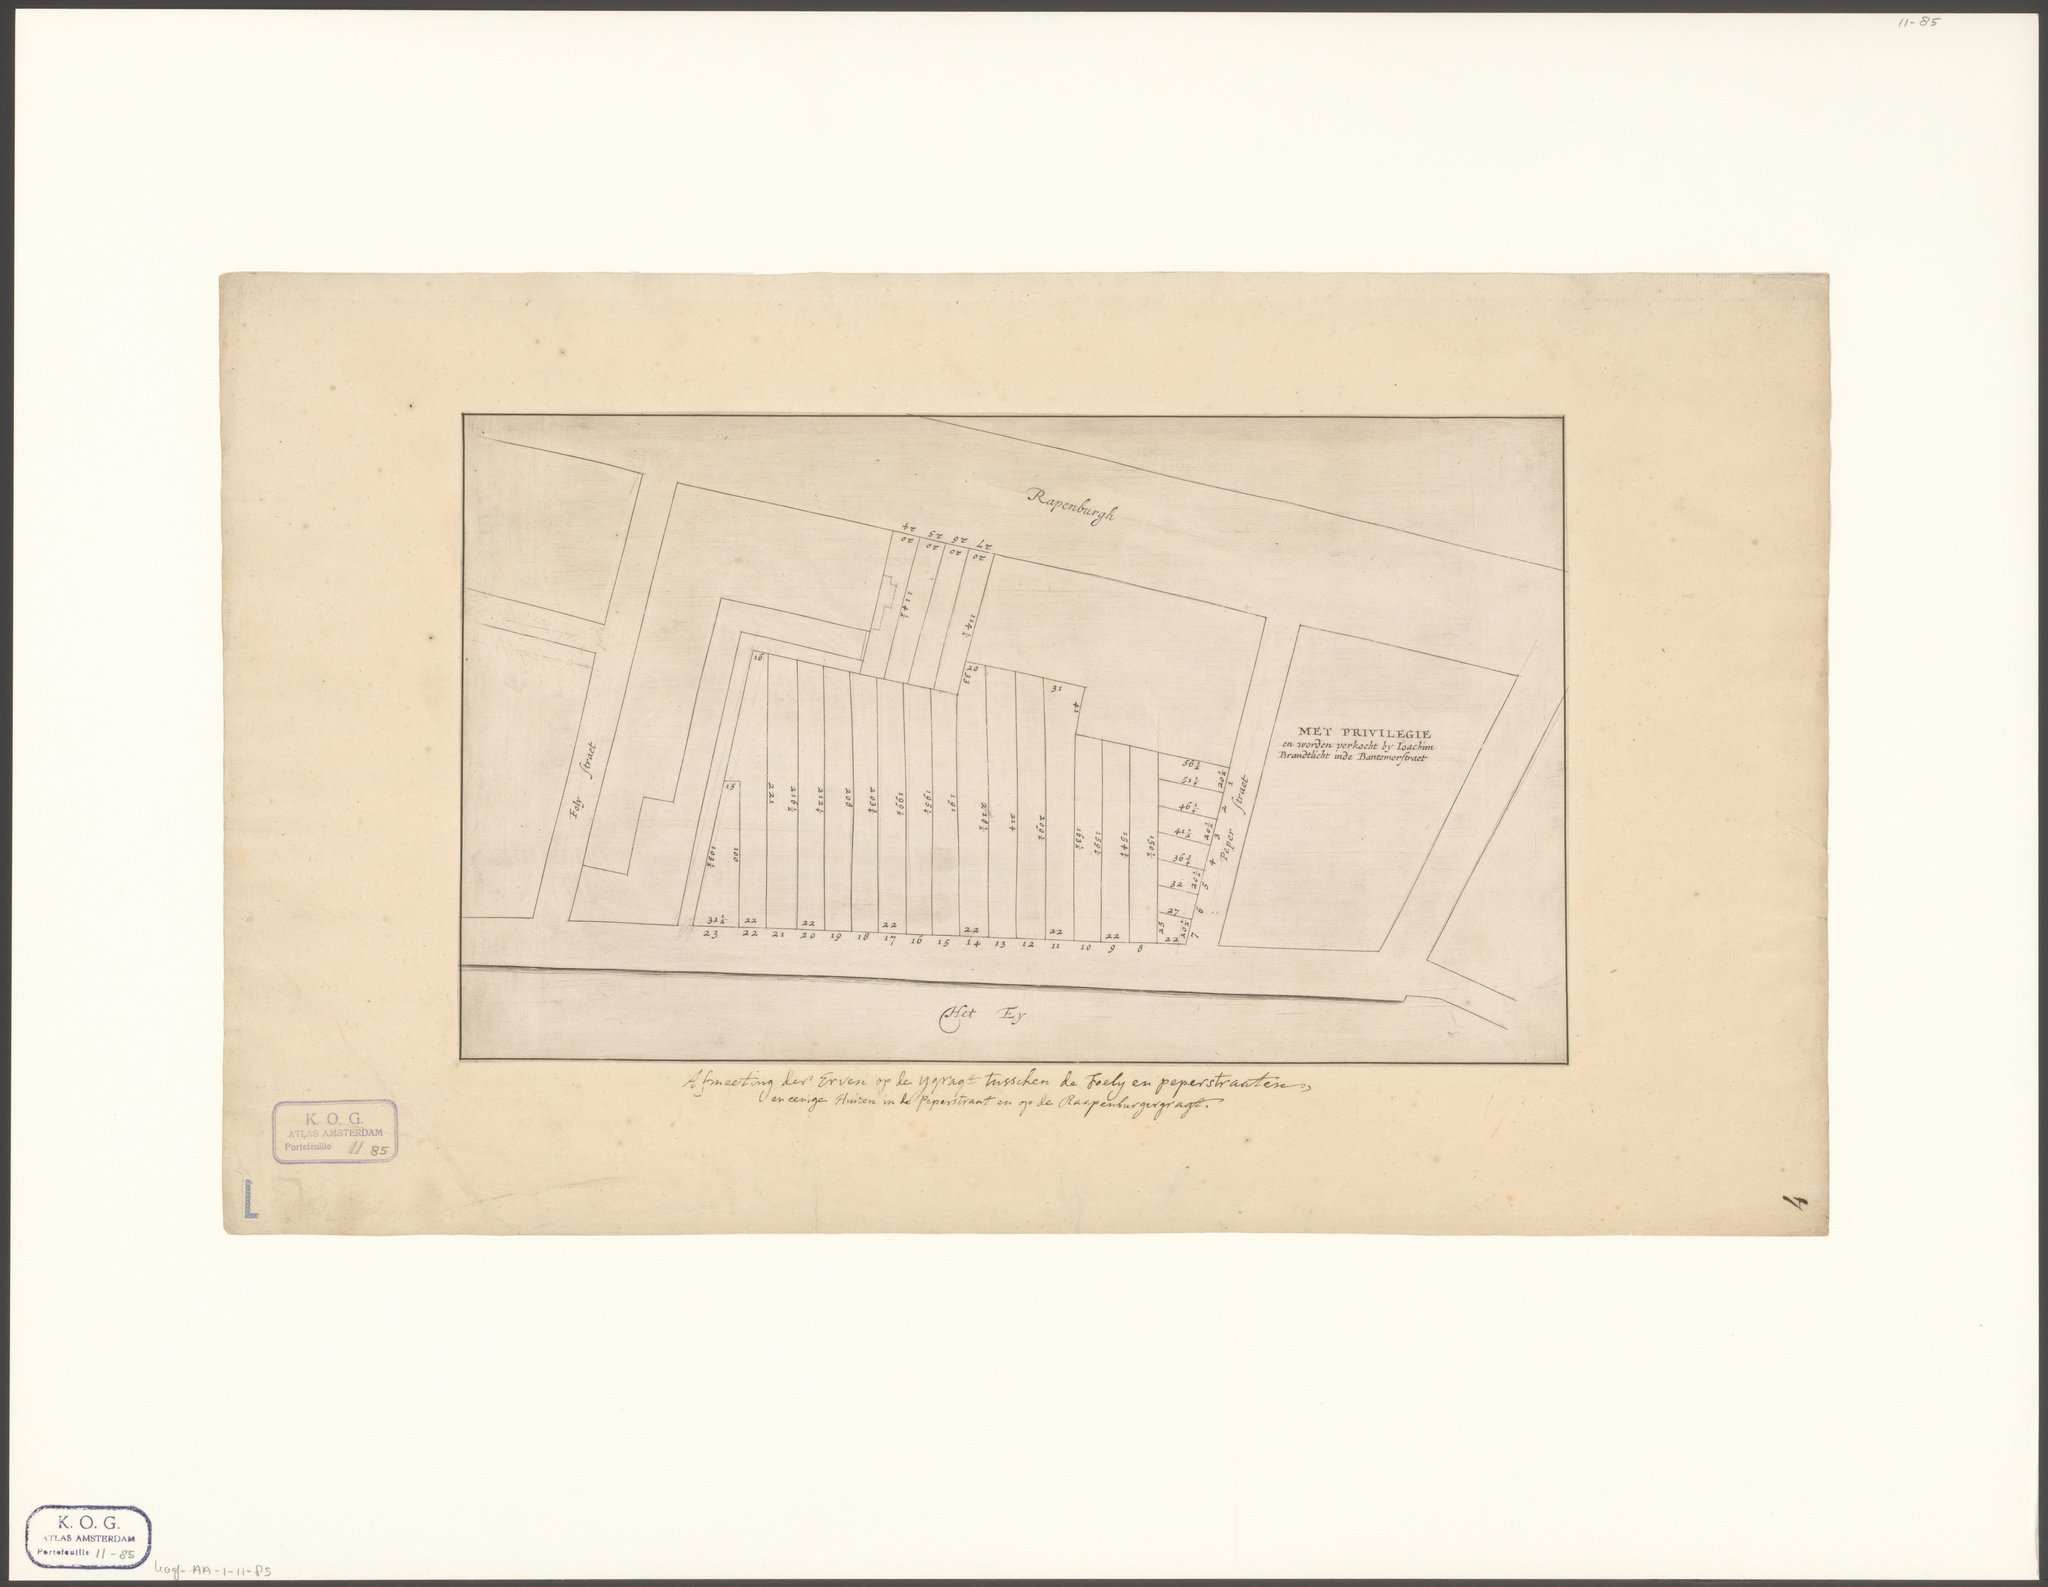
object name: area plan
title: Plattegrond van de percelen aan de IJgracht tussen de Foeliestraat en de Peperstraat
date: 1650-1750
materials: paper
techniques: engraving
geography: amsterdam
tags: plan ~ architecture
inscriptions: inscription: ‘Afmeeting der Erven (...) op de Raapenburgergragt.’, collector's mark: ‘11.85’ Lugt 1641b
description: Onderwerpsrubriek binnen de Atlas Amsterdam: Prinsengracht, Korte Prinsengracht, Prins Hendrikkade. Zie ook Portefeuille 1: gezichten van het IJ op de stad.